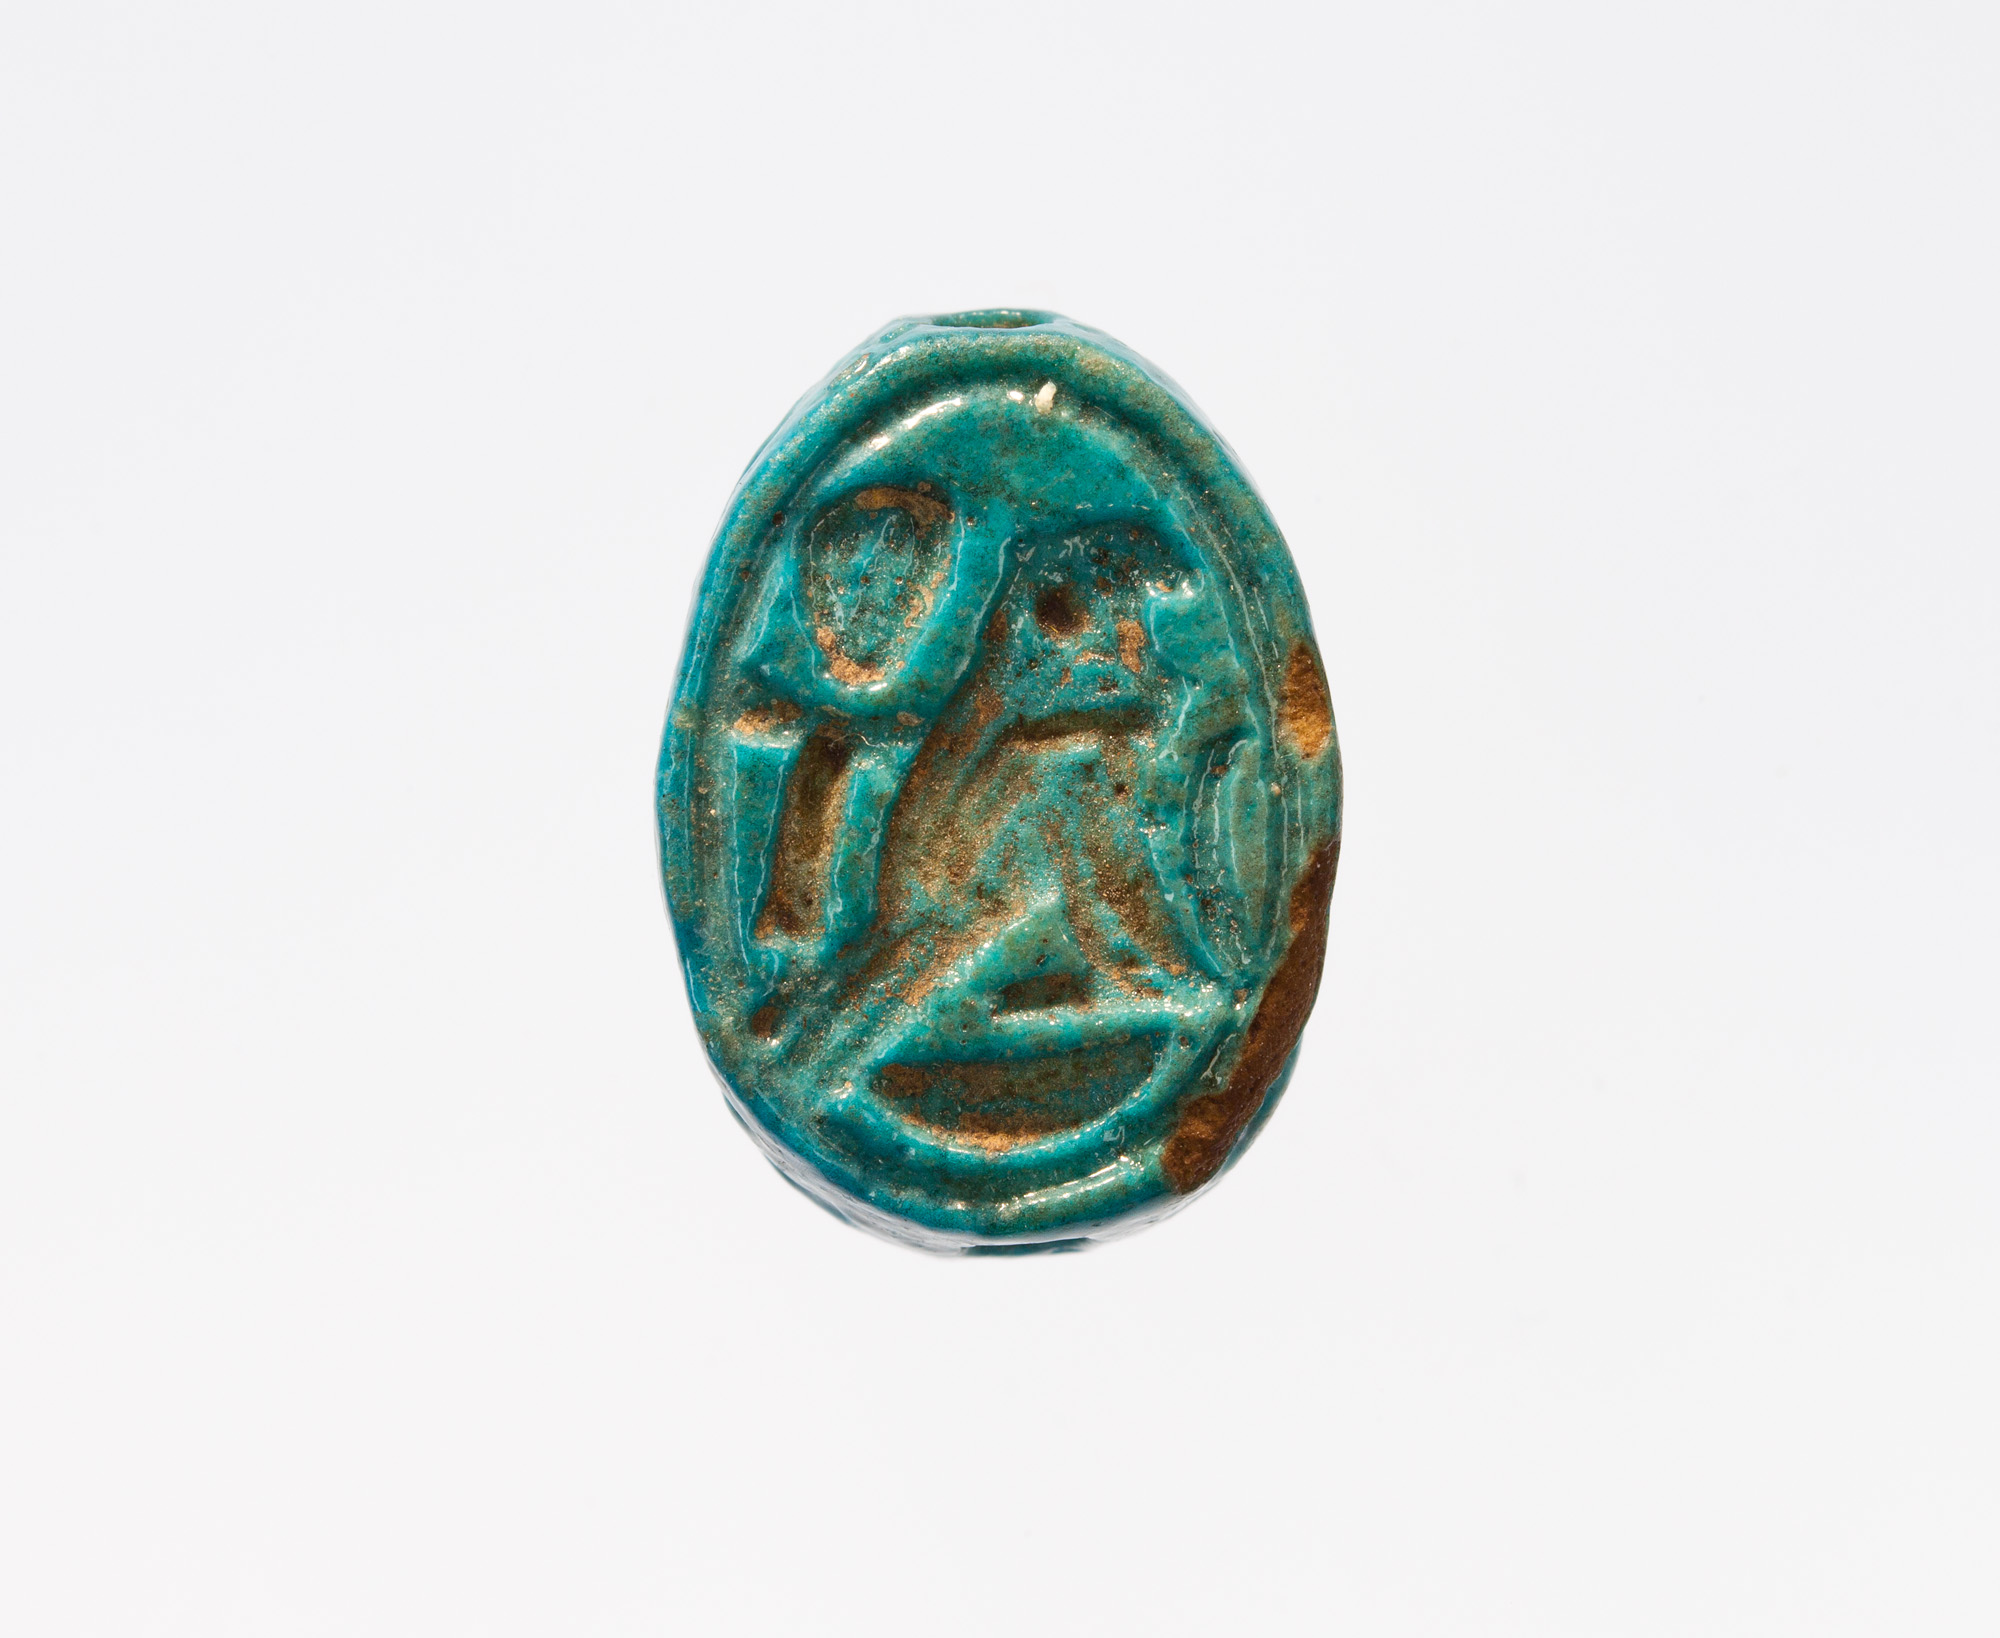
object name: scarab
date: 1479-1458 BCE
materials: faience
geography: egypt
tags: scarabs